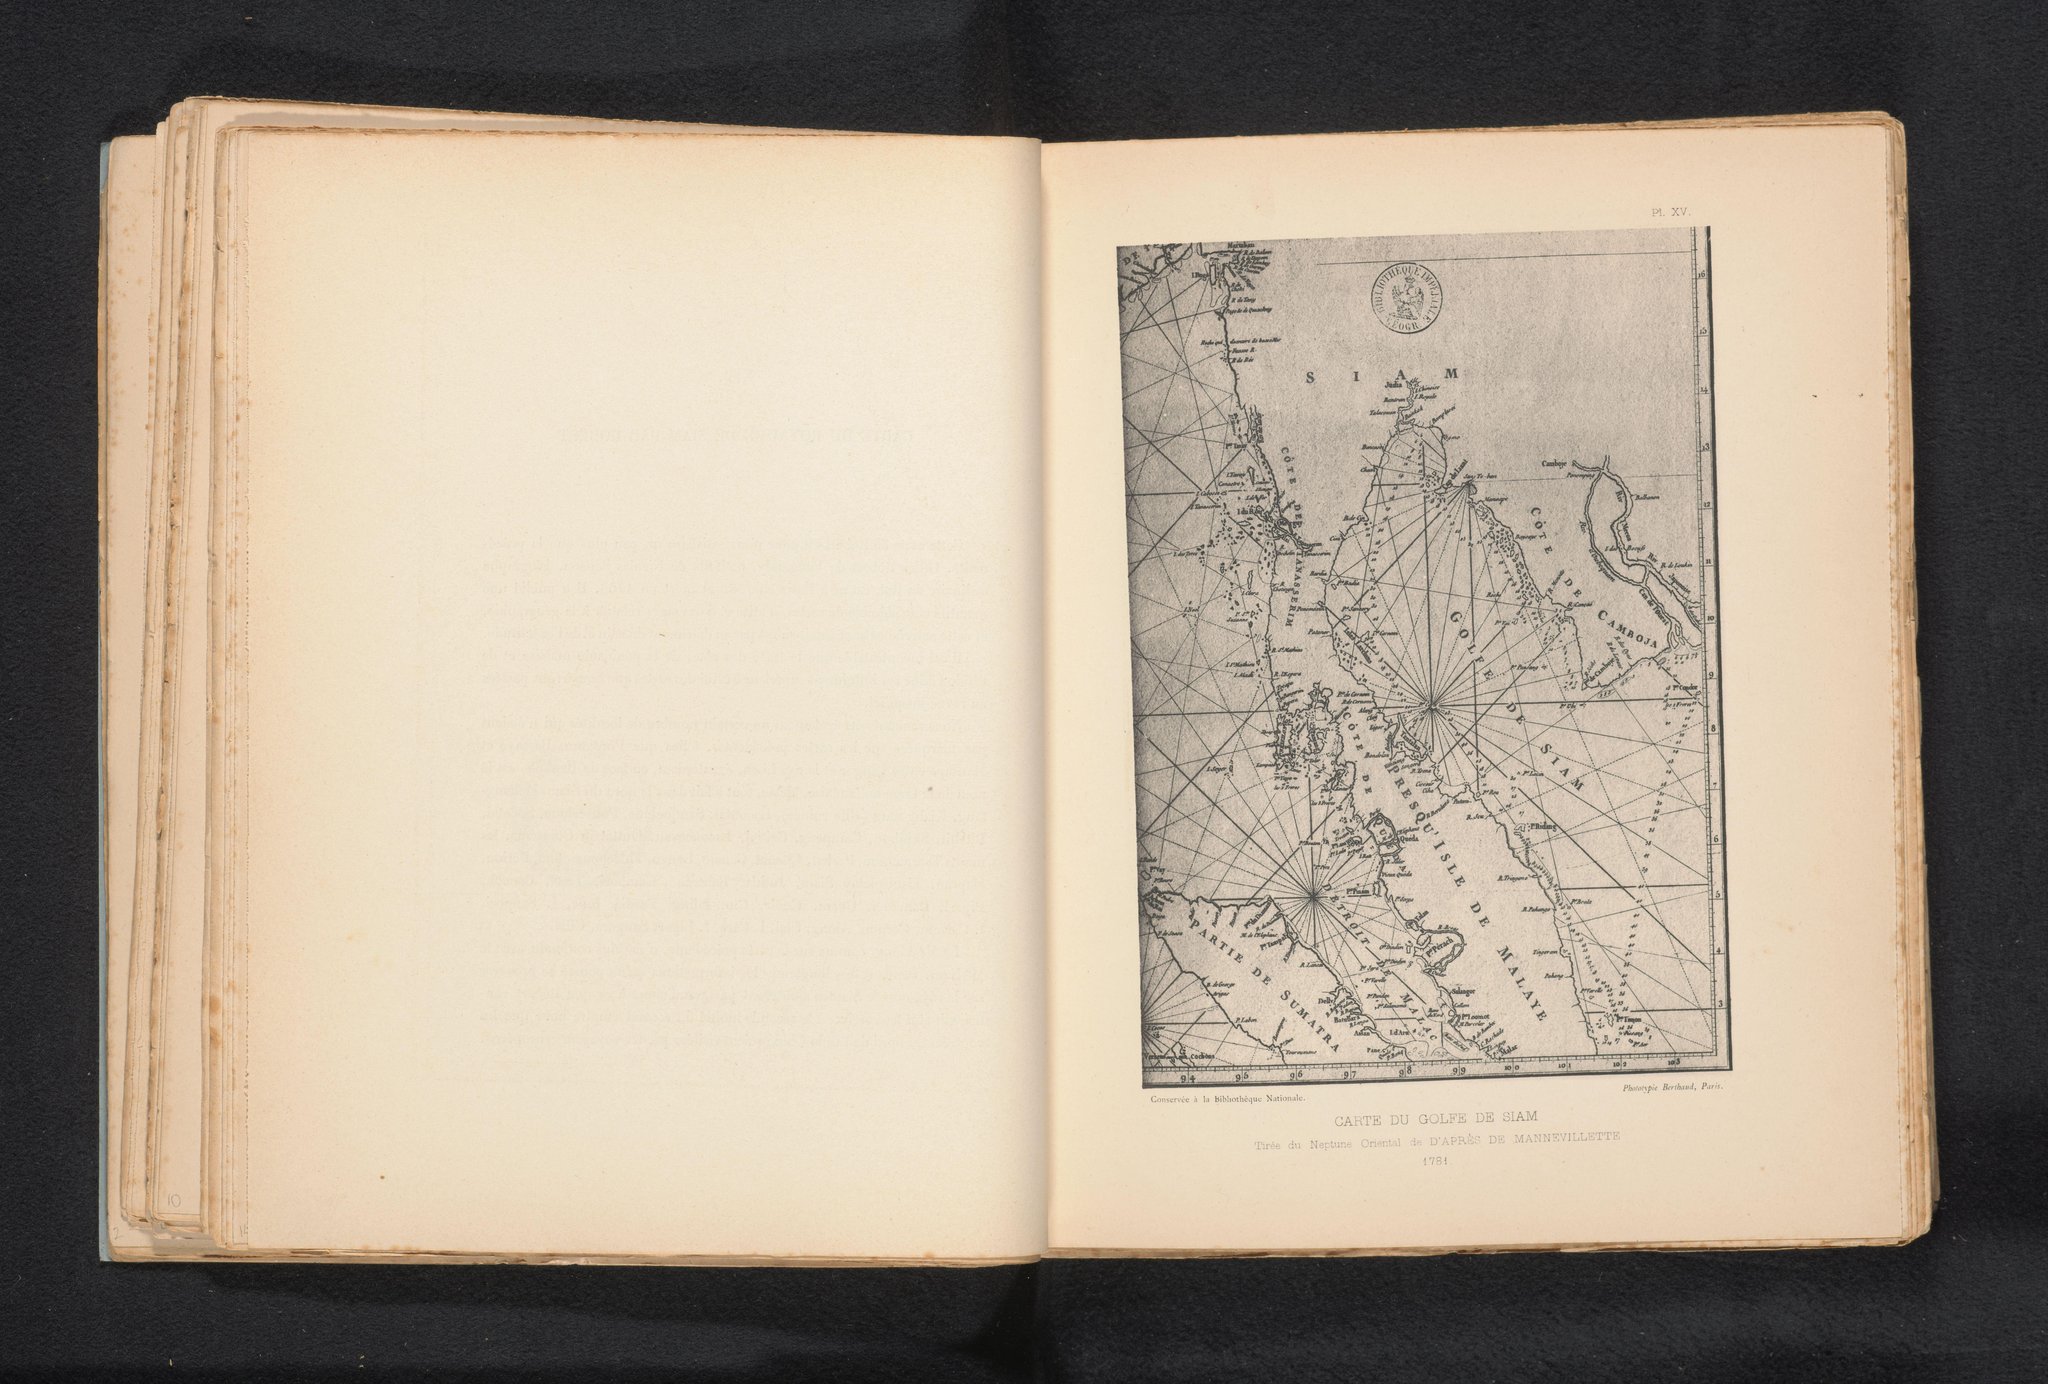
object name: photomechanical print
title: Reproductie van een kaart van de Golf van Thailand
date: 1890-1895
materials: paper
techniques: photograph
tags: maps, atlases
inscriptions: inscription: ‘Tirée du Neptune Oriental de d'après de Mannevillette/ 1781.’, collector's mark: ‘Société d'Emulation de l'Ain/ Bourg/ Bibliothèque’, inscription: ‘Pl. XV/ Conservée à la Bibliothèque Nationale’